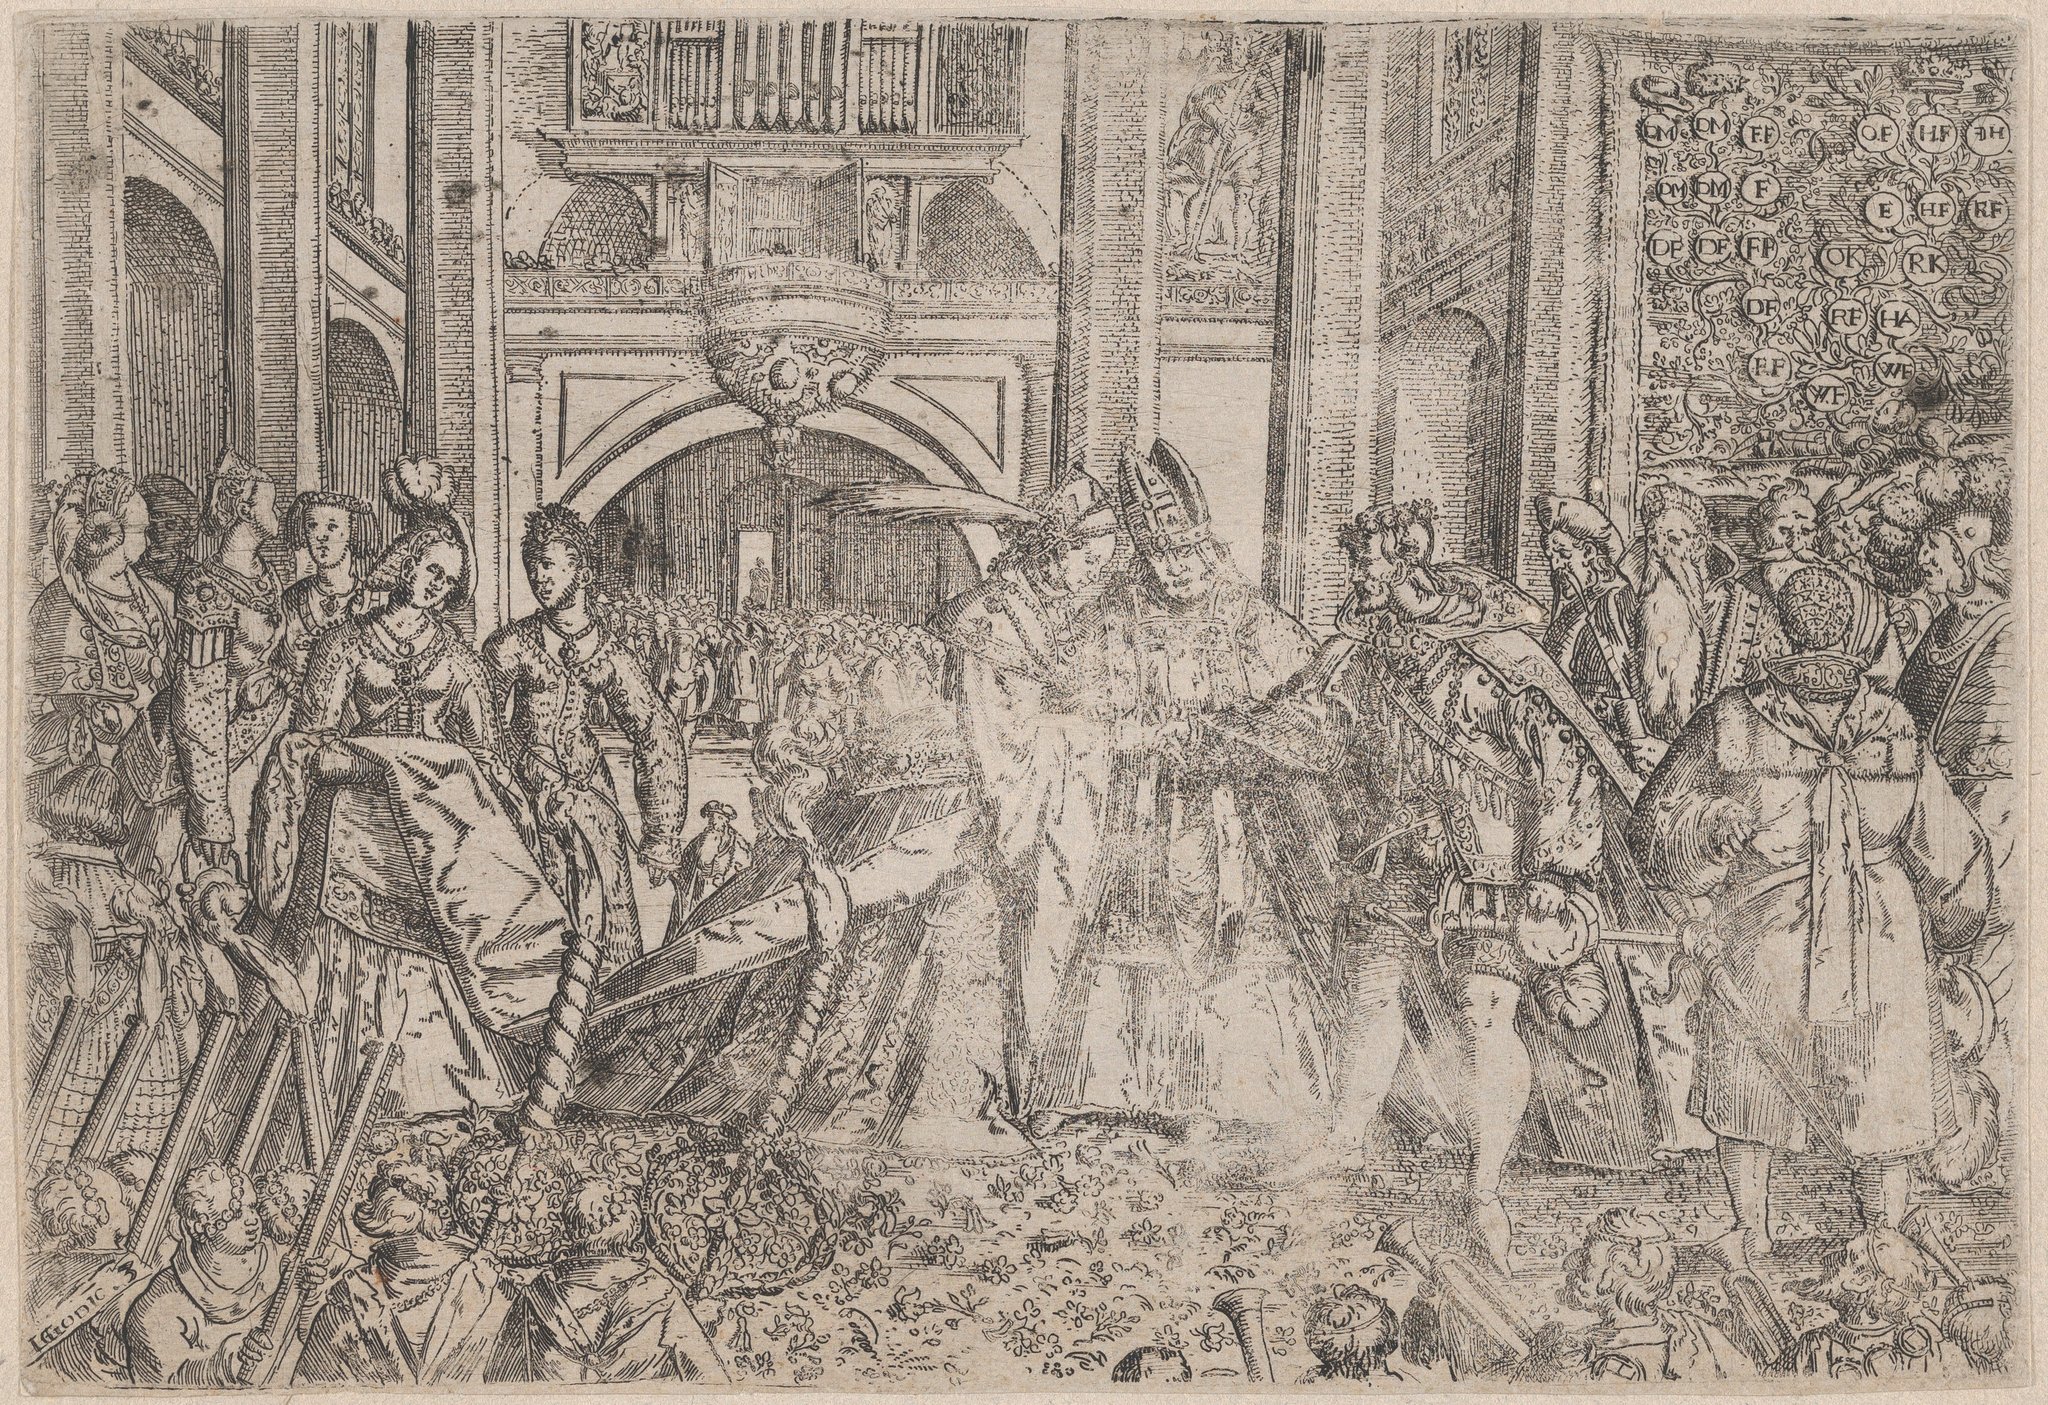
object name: print, fete, ornament architecture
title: A princely wedding performed by a bishop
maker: anonymous, german, 16th century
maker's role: artist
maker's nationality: german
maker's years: 1500-1600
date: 1567-1600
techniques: etching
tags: men,women,bishops,weddings